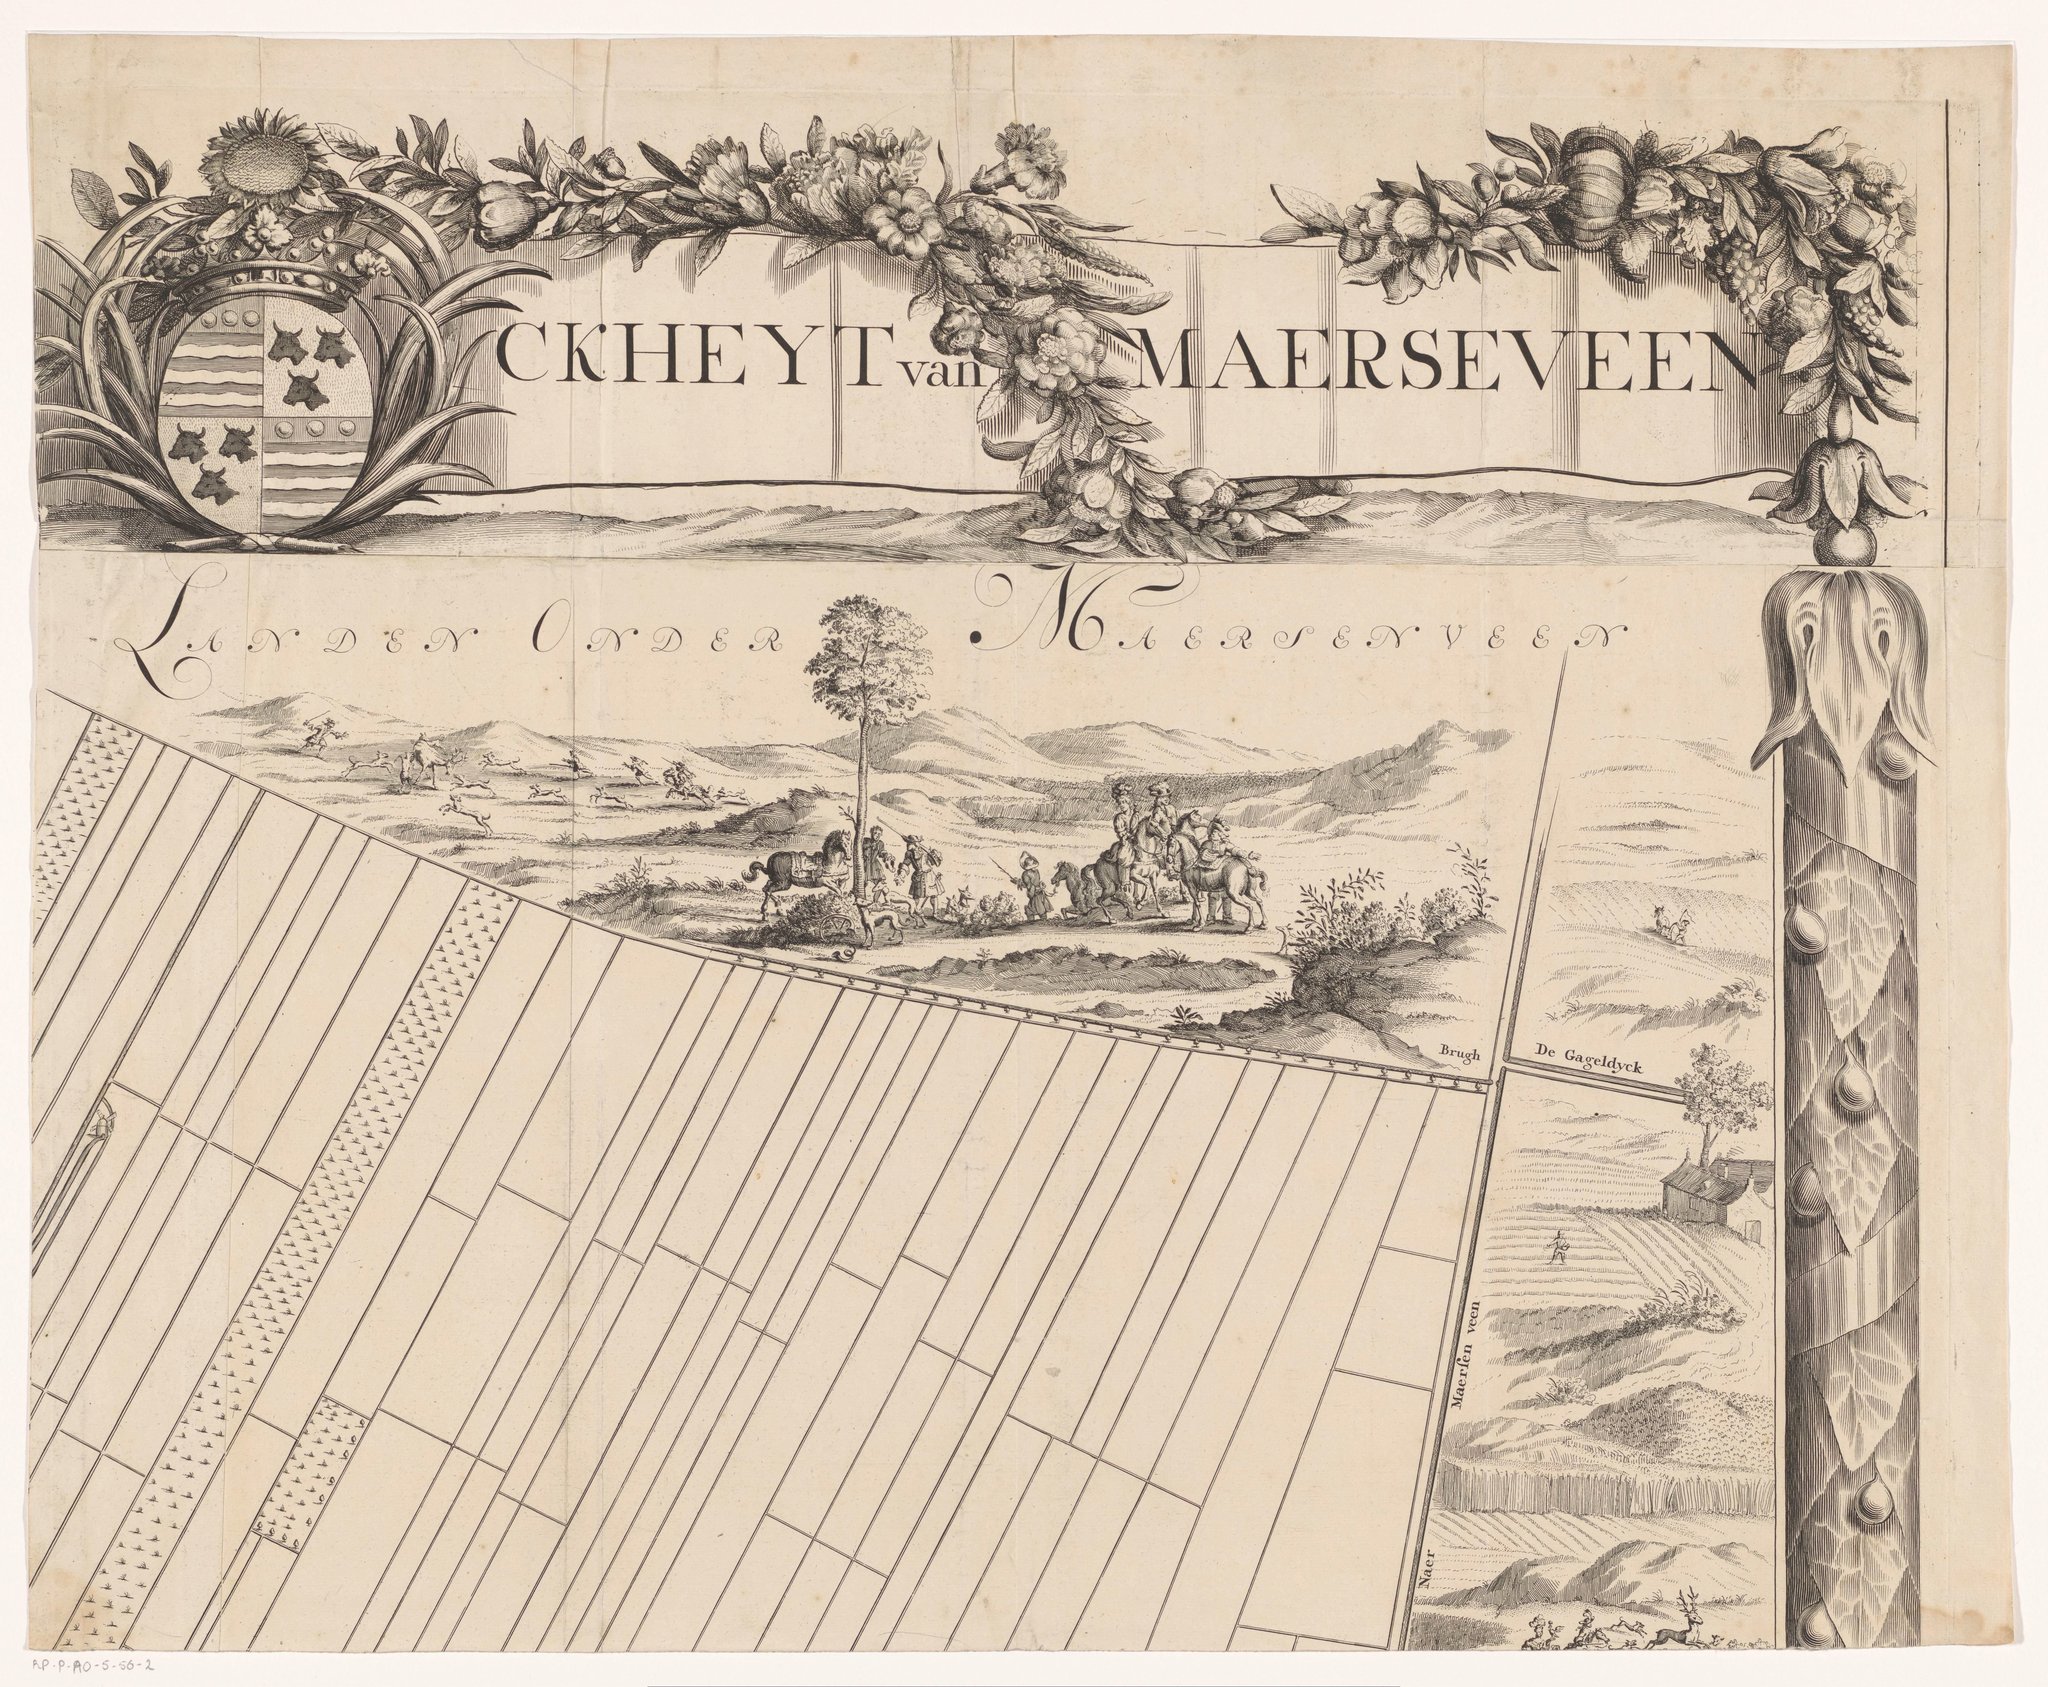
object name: area plan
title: Een gedeelte van de heerlyckheyt van Maerseveen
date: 1690-1691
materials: paper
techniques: engraving, etching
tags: coat of arms (as symbol of the state, etc.), hunting, chase, plants; vegetation (+ ornamental variants of plants), ribbon, scroll, banderole ~ ornament, maps of cities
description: Deel (rechtsboven) van een plattegrond van de heerlijkheid Maarsseveen.